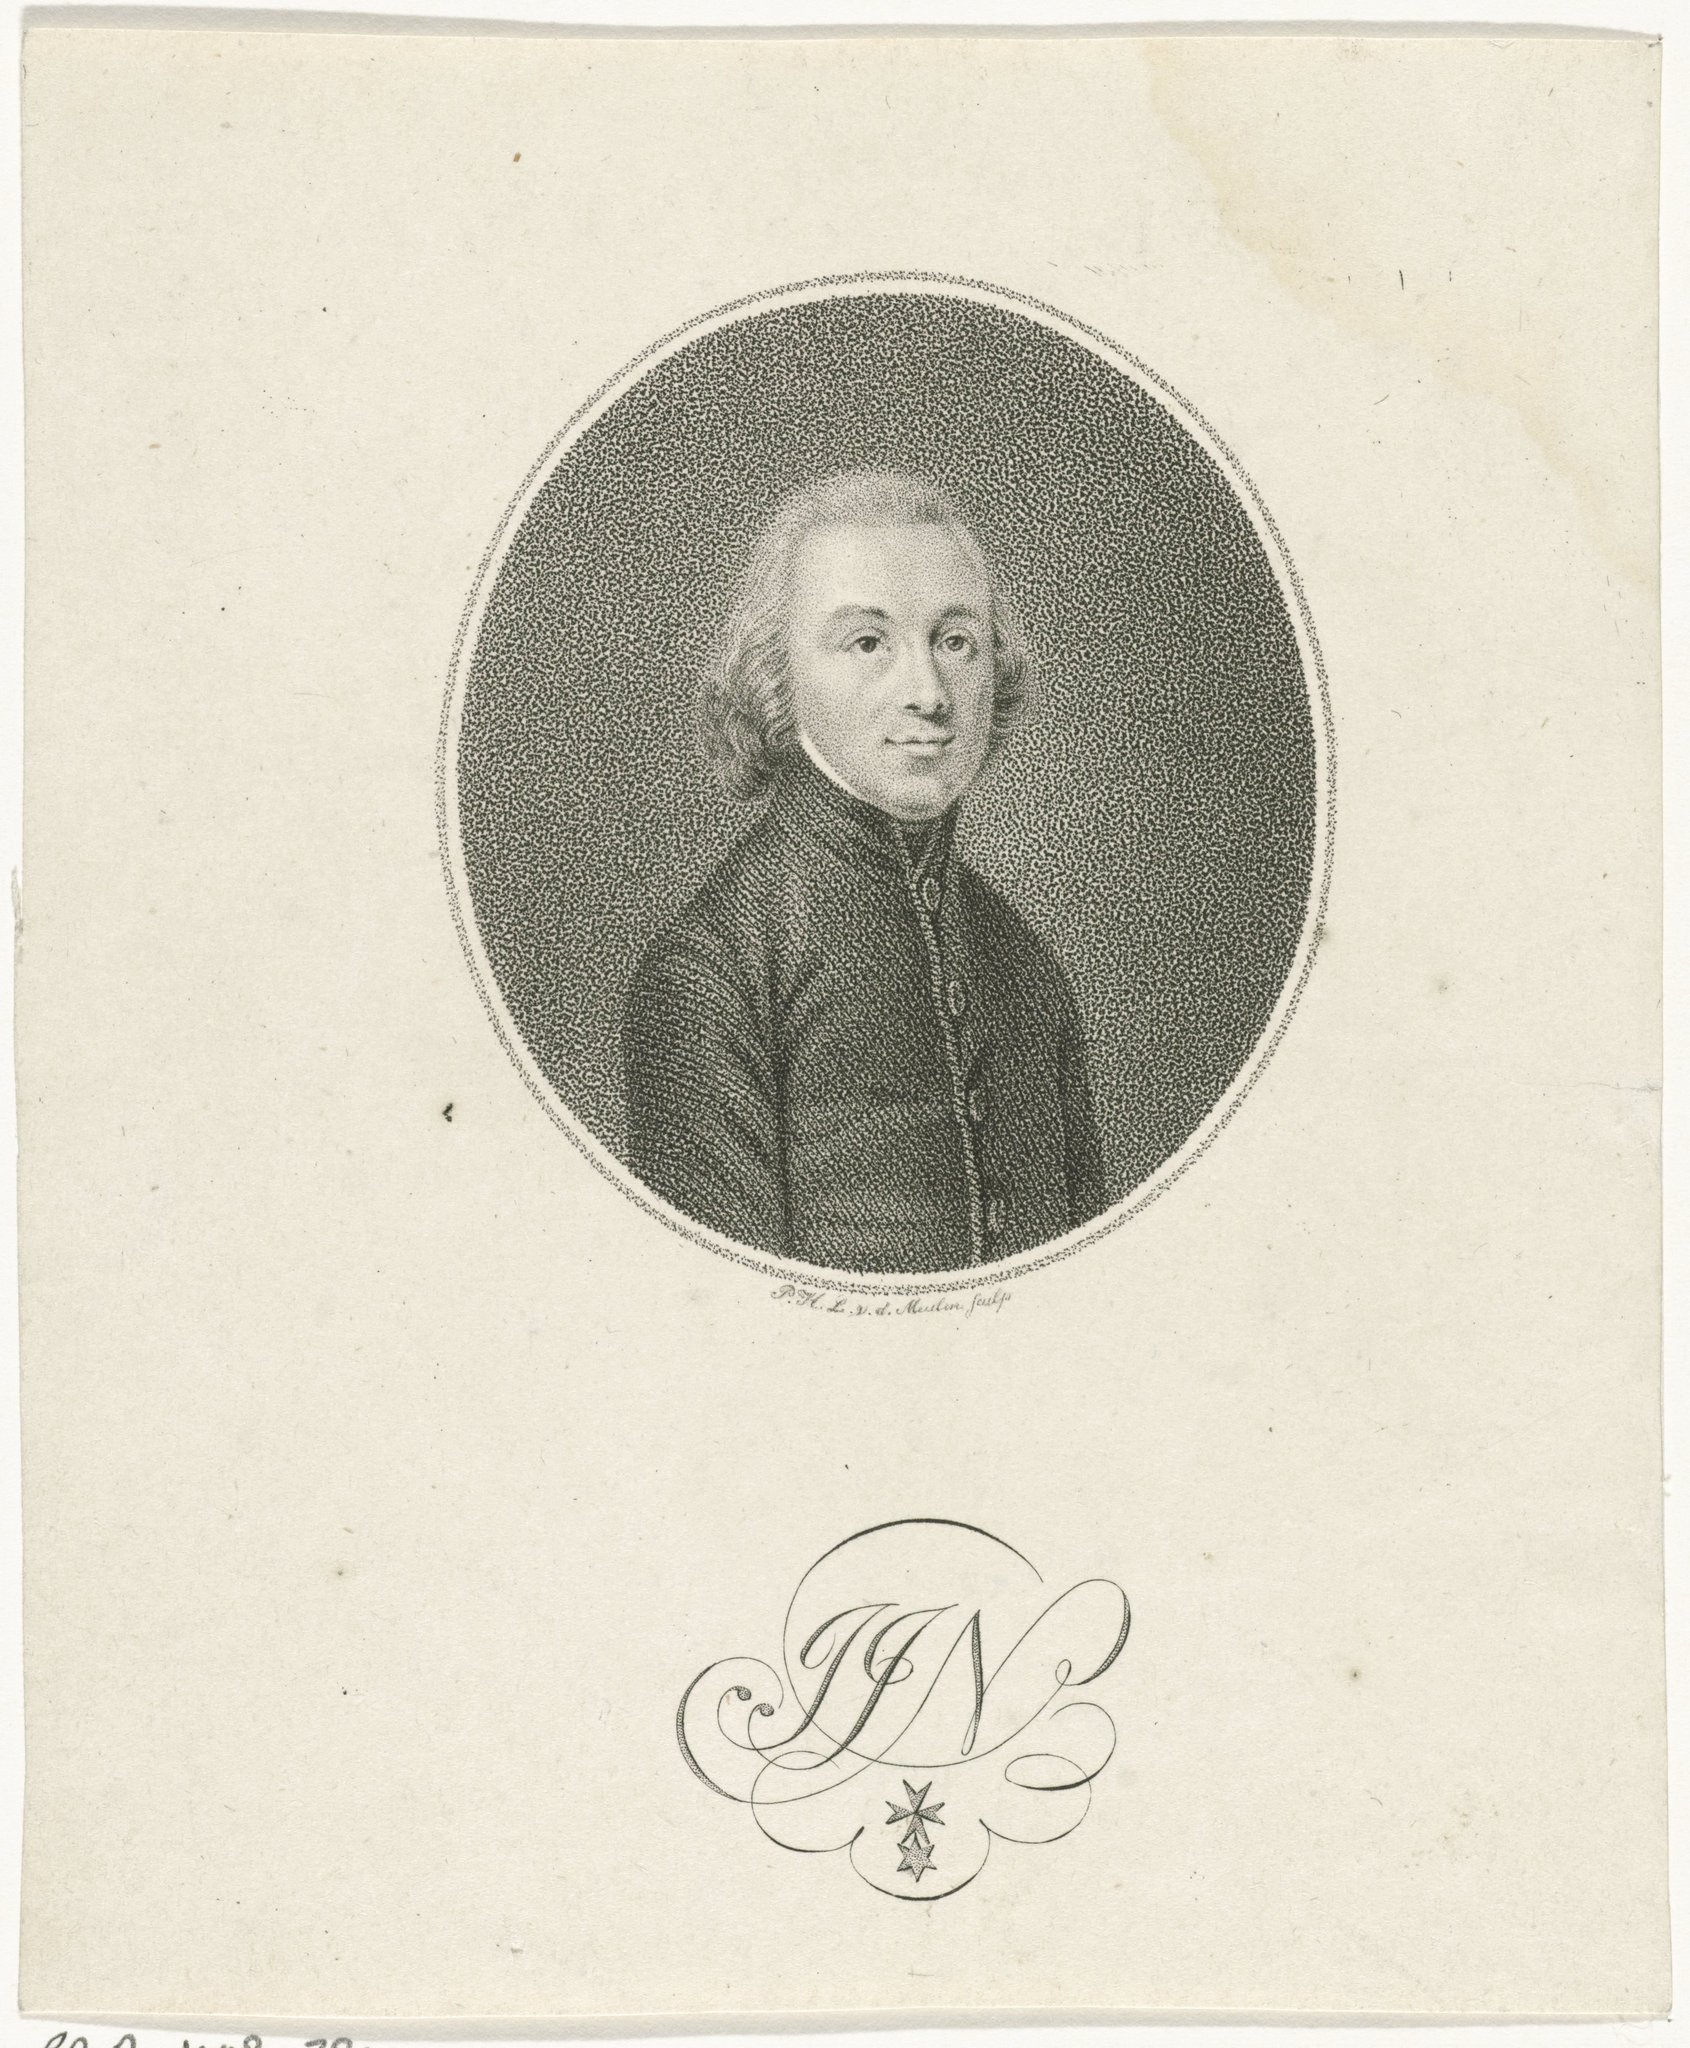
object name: print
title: Portret van Johann Joseph Natter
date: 1790-1858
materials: paper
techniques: stippled etching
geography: amsterdam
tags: schrijver, theoloog, johann joseph natter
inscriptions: collector's mark: Lugt 2228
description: Prent gebruikt in: Natter, Johann Joseph. Twaalf leerredenen, bĳ onderscheidene gelegenheden opgesteld en uitgesproken. Amsterdam: Jan Steven van Esveldt-Holtrop, 1807.